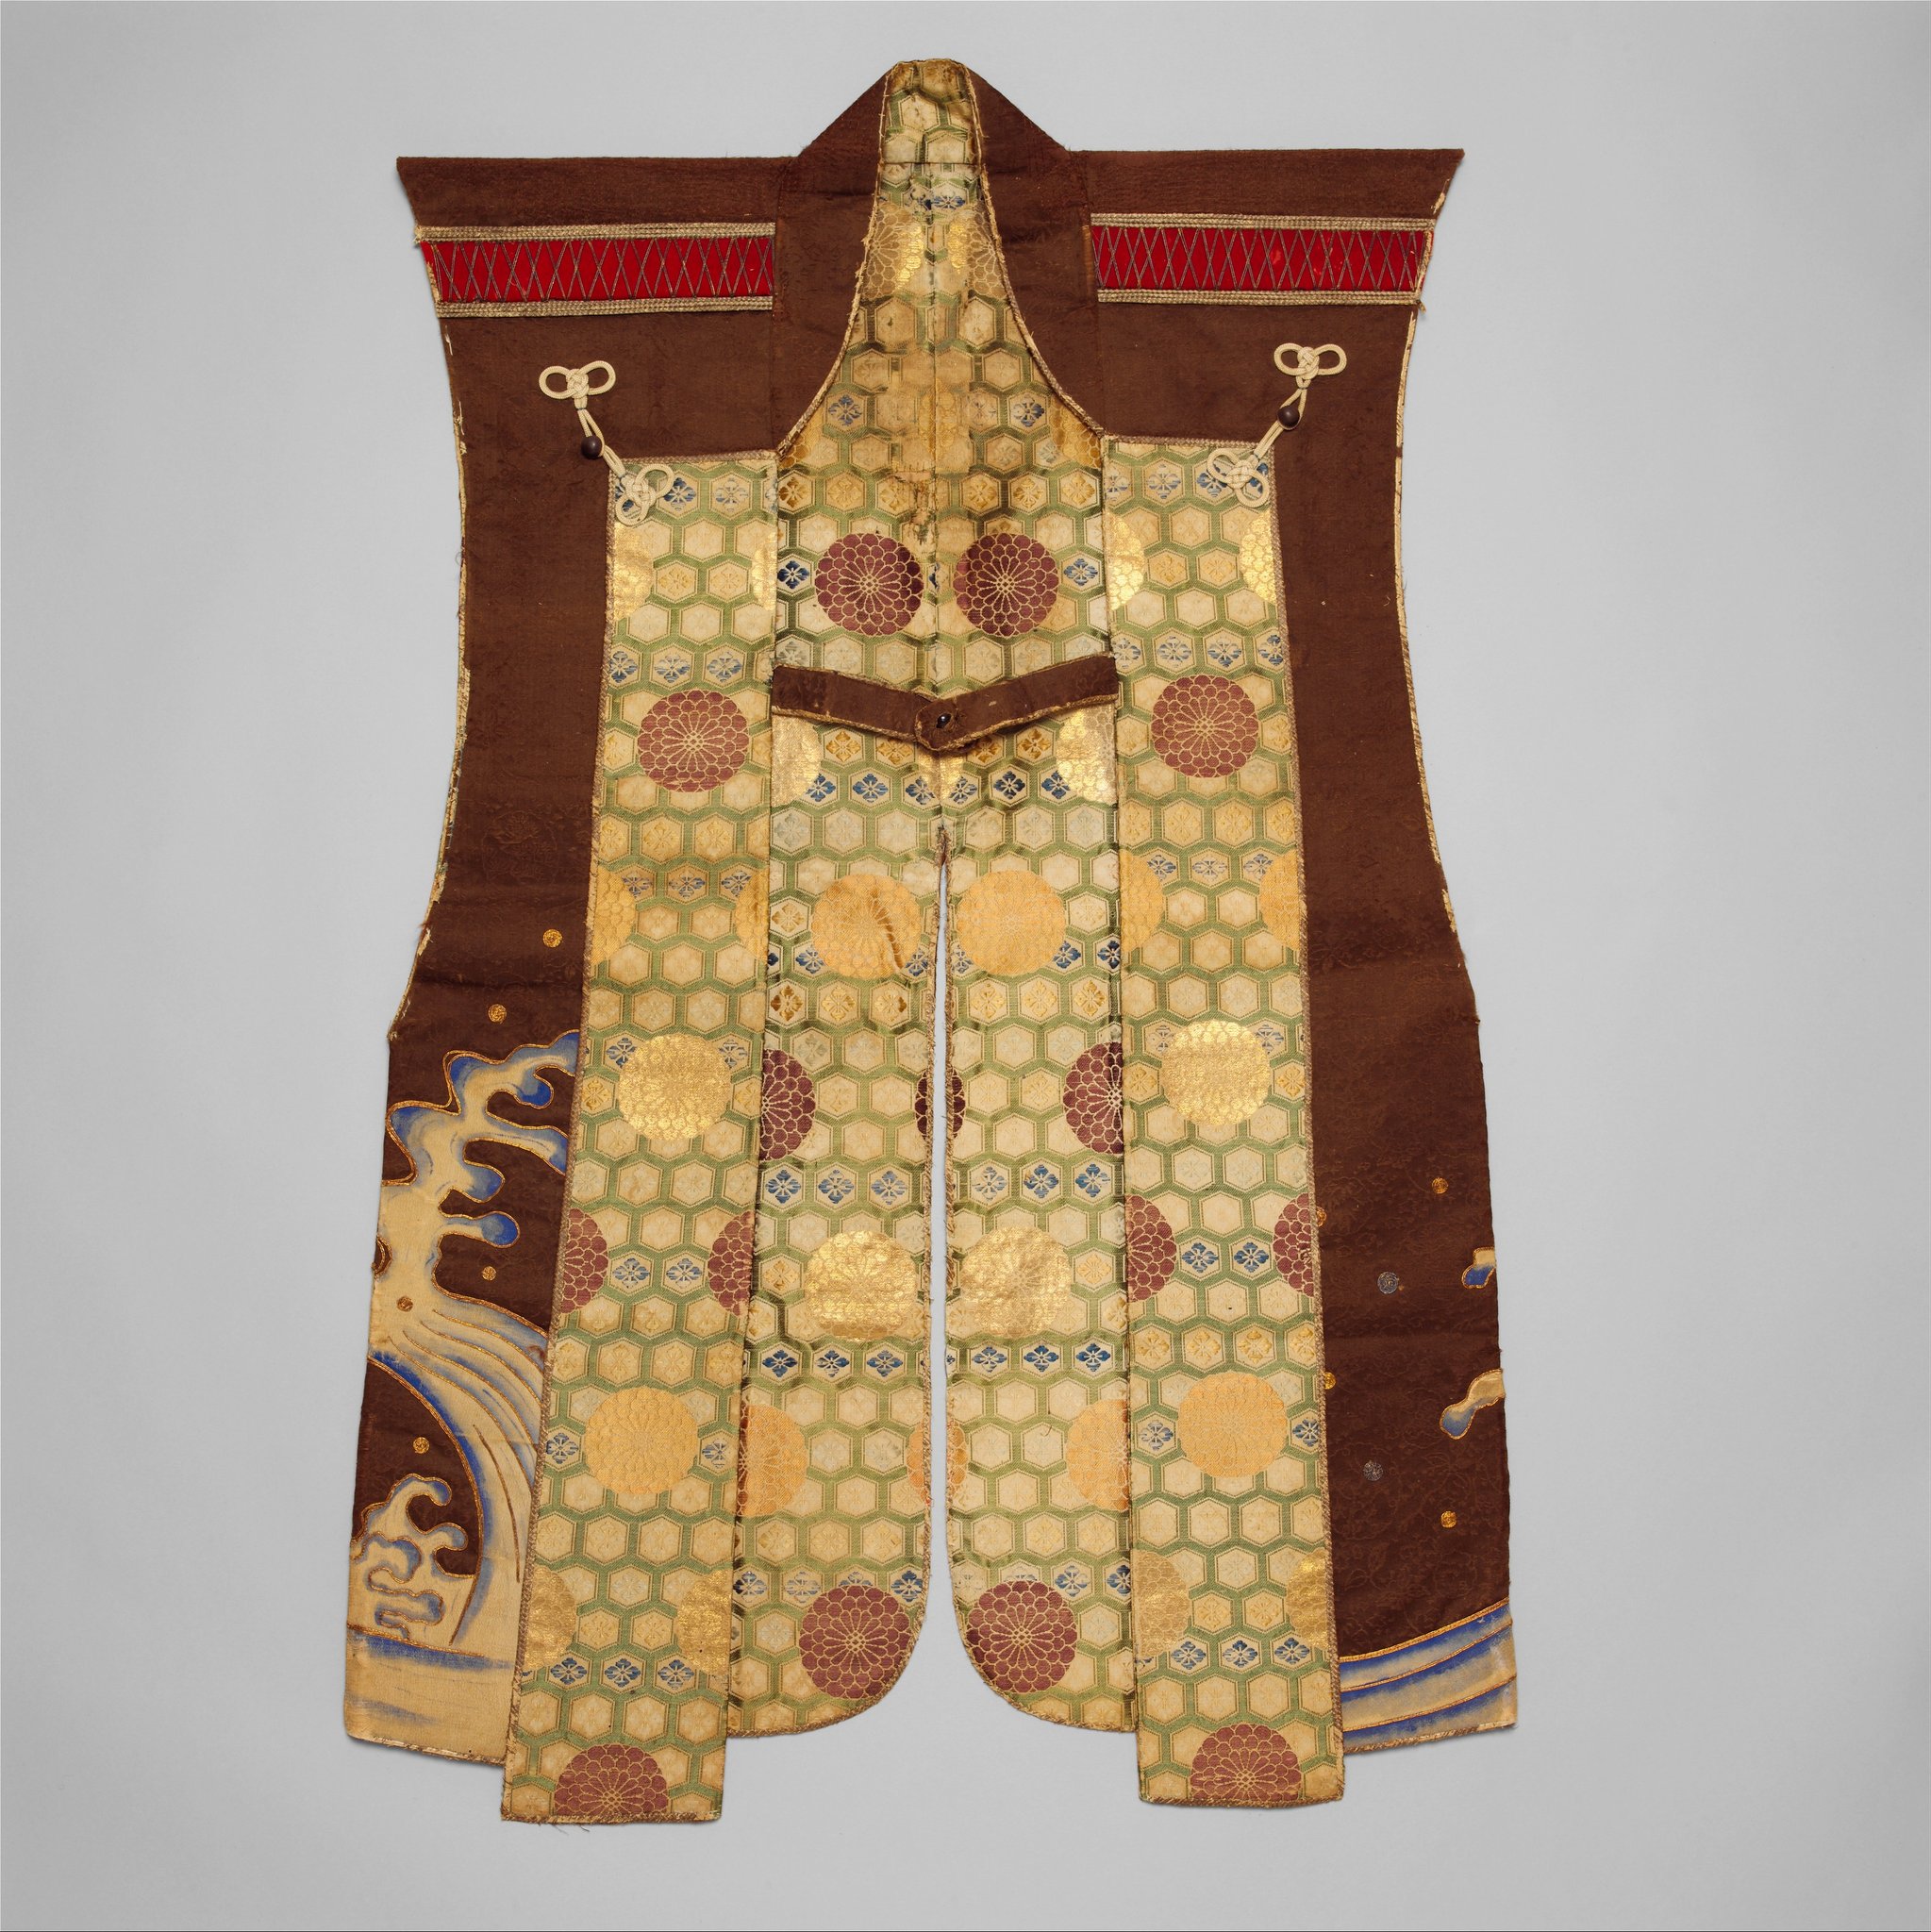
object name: surcoat i jinbaori i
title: Surcoat (Jinbaori)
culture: japanese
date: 1601-1700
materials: felt, lacquer, metal thread, silk, wood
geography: japan